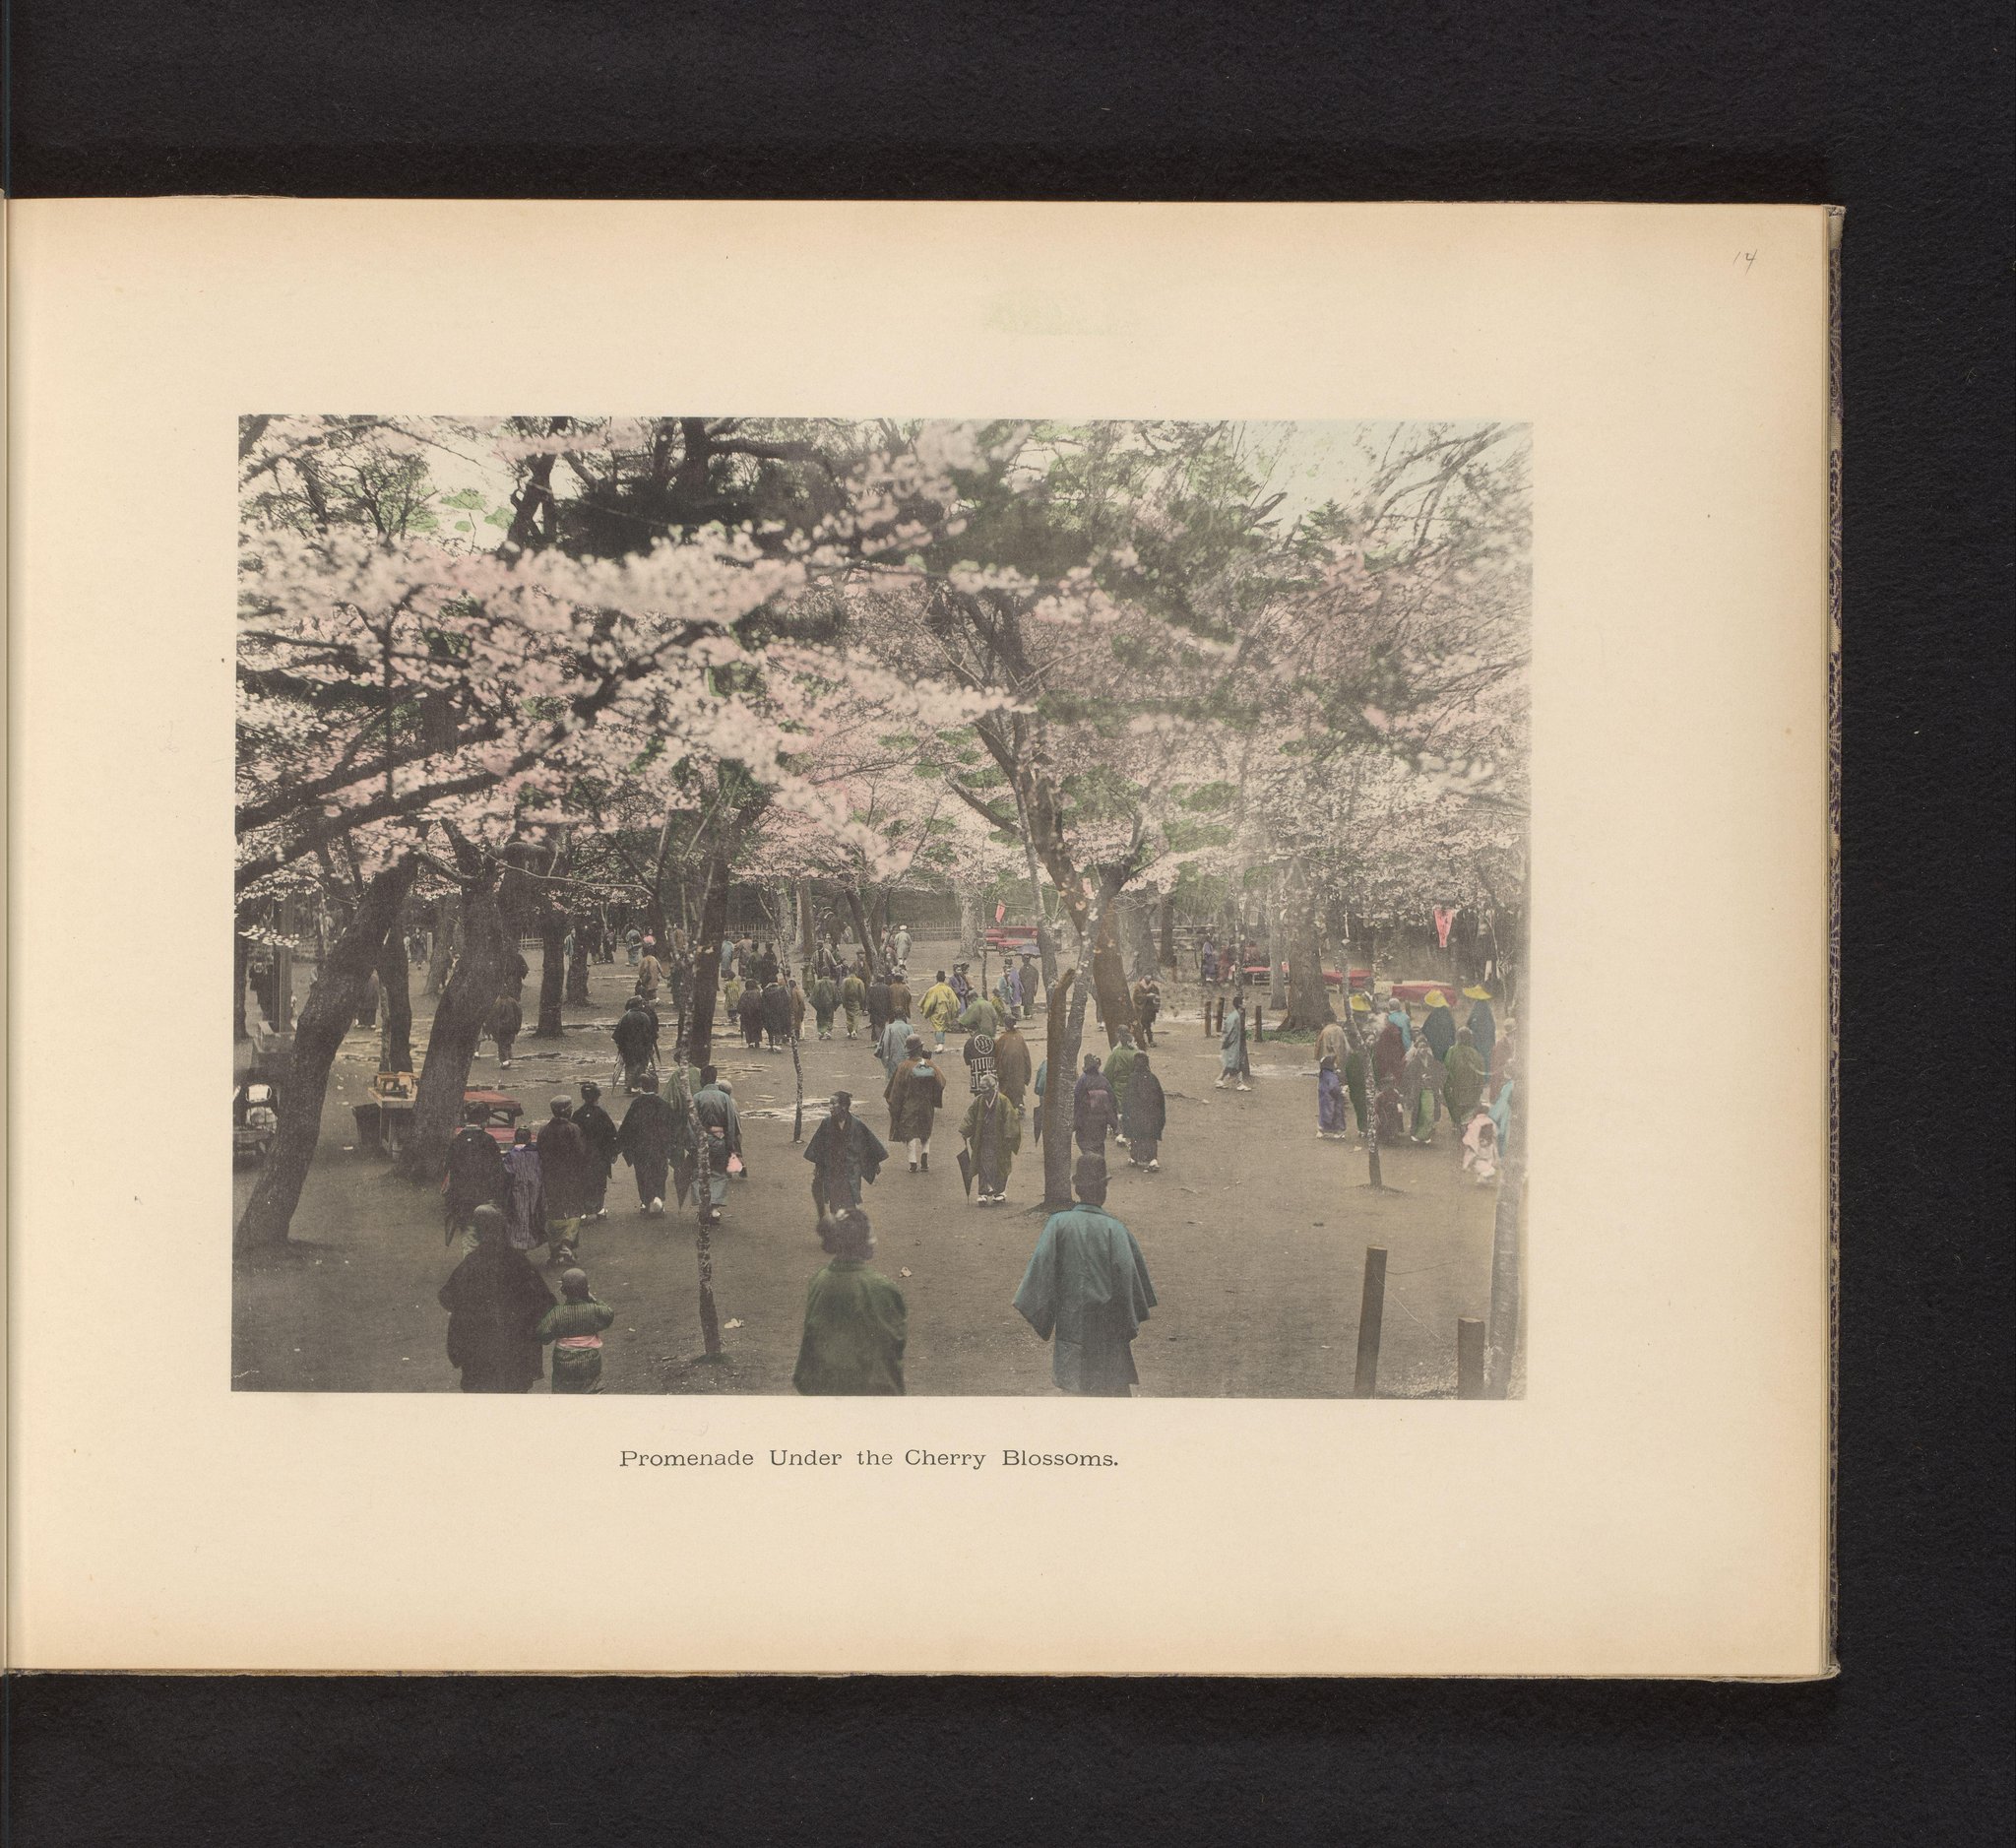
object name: page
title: Promenade Under the Cherry Blossoms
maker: kazumasa ogawa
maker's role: auteur, fotograaf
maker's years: 1860-1929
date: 1892-1897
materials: paper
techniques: photograph, hand coloring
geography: uenopark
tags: park, trees: cherry-tree, road, path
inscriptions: number: ‘14’